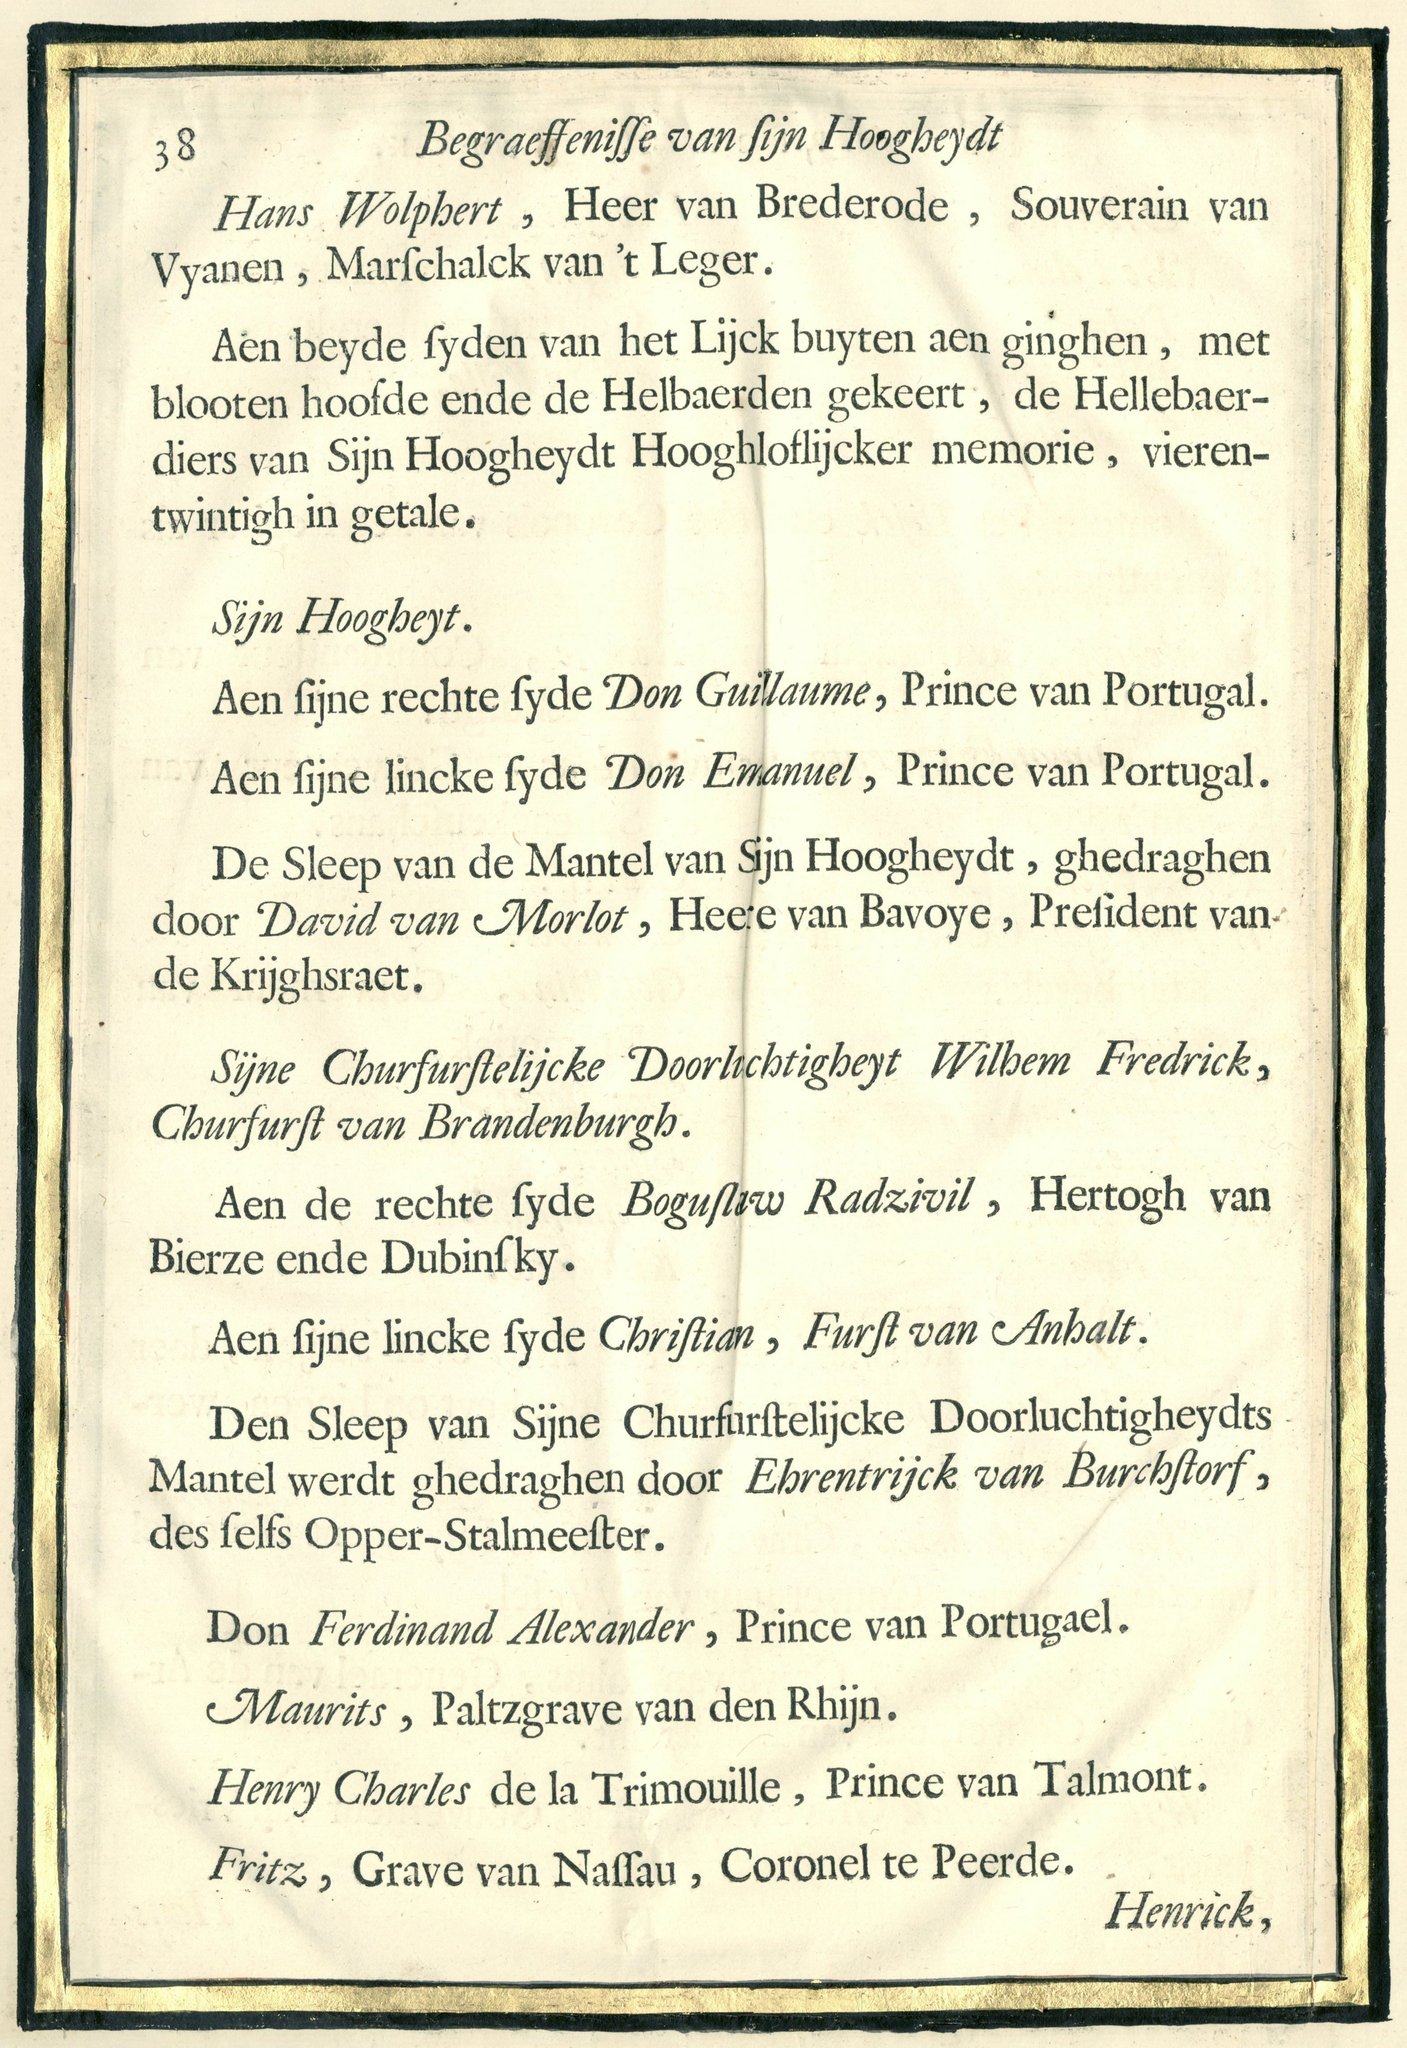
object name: text sheet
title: Begraeffenisse van syne hoogheyt Frederick Henrick. Luxe ingekleurde uitgave van de prenten van de begrafenisstoet van Frederik Hendrik in 1647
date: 1651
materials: paint, paper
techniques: letterpress printing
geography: amsterdam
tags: delft, frederick henry (prince of orange)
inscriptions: date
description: Pagina 38 van de beschrijving van de begrafenis van Frederik Hendrik. Blad uitgeknipt, versierd met goud en ingeplakt in de luxe editie uit ca. 1755 van het boek 'Begraeffenisse van syne hoogheyt Frederick Henrick' van Pieter Post, uitgegeven te Amsterdam in 1651.